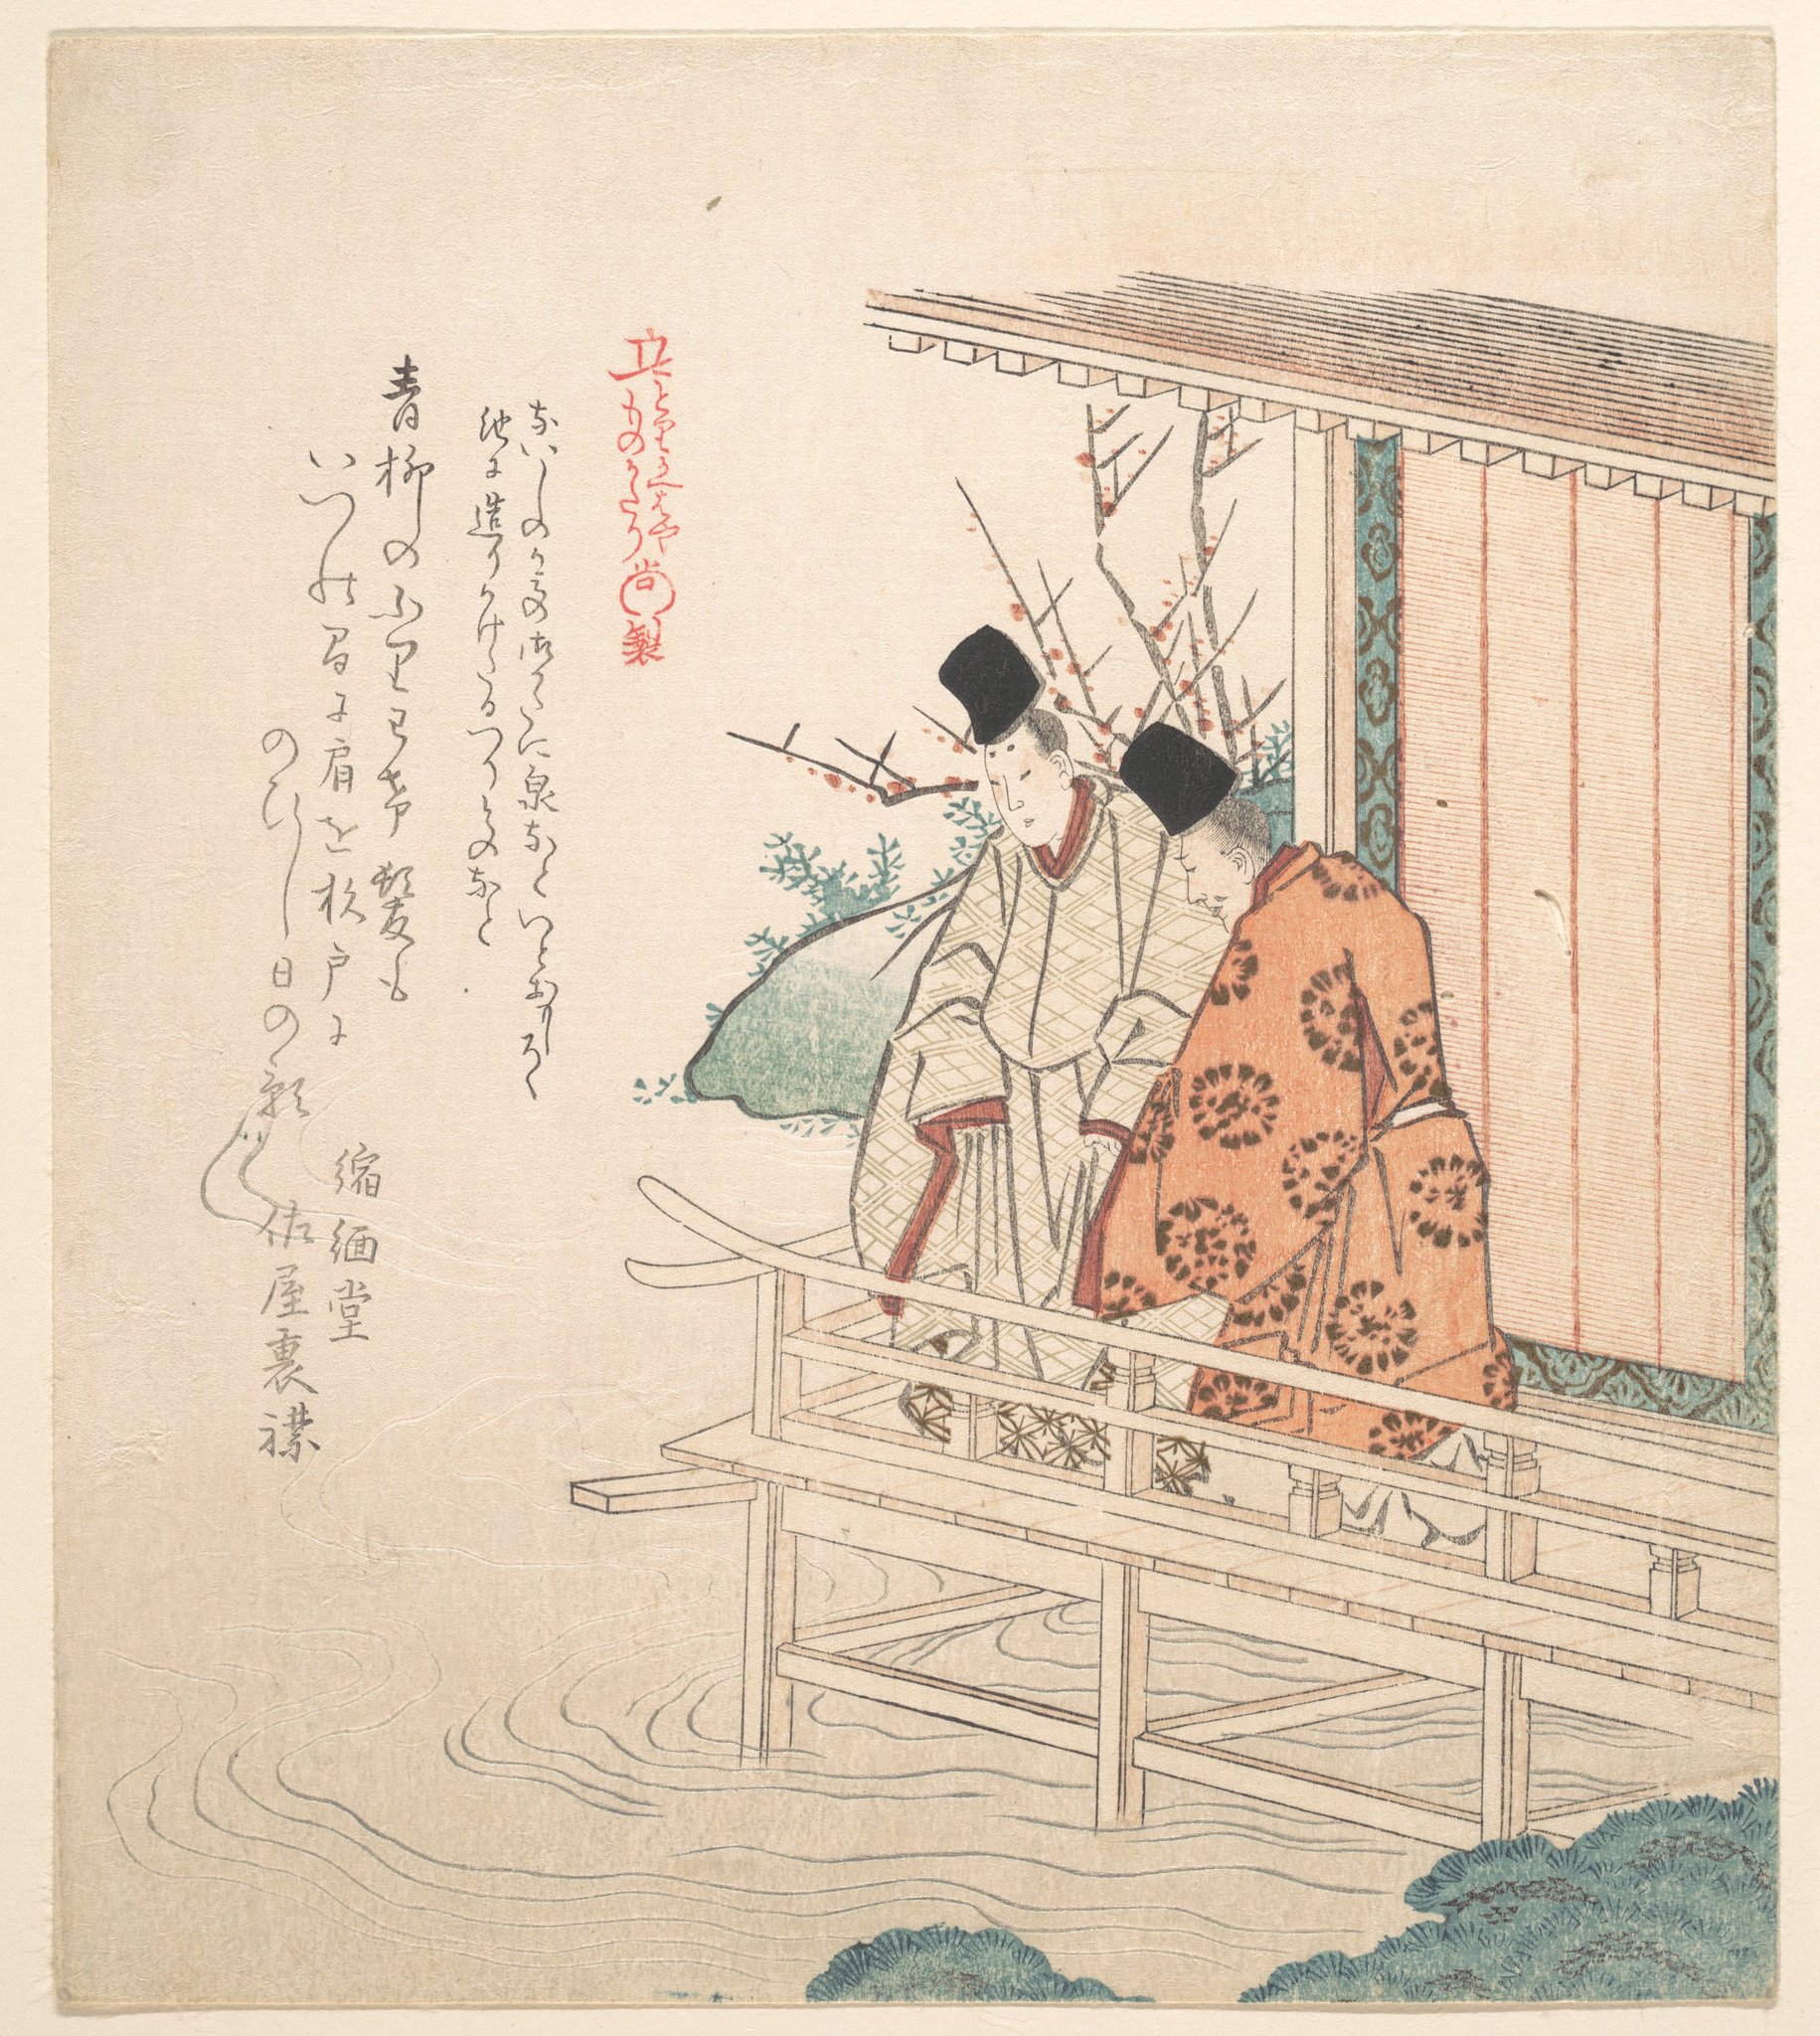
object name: print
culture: japanese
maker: totoya hokkei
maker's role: artist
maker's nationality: japanese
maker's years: 1780-1850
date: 1780-1850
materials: ink, paper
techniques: surimono, woodblock print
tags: balconies,men